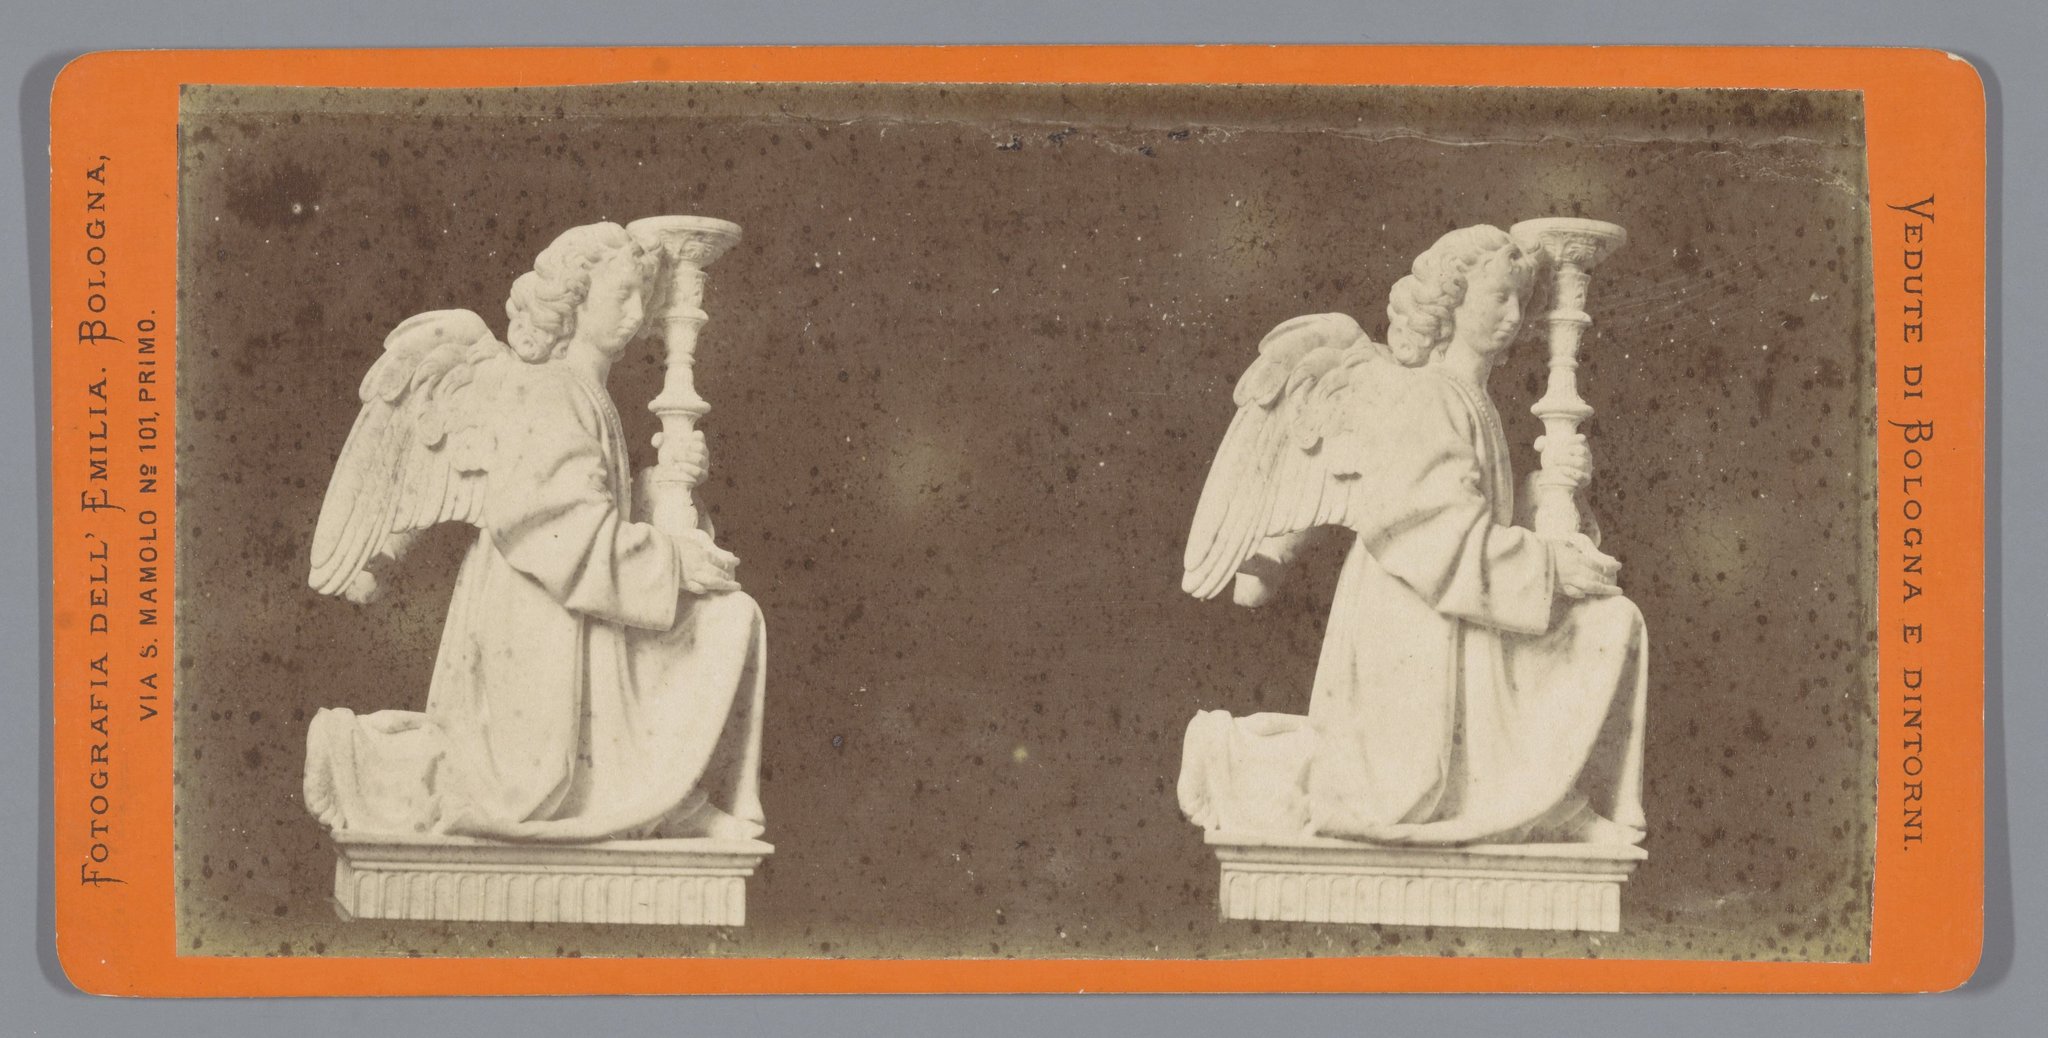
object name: stereograph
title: Vedute di Bologna e Dintorni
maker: Anonymous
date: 1868-1890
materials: cardboard, paper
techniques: albumen print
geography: bologna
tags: angel(s) with torch, piece of sculpture, reproduction of a piece of sculpture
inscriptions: address: ‘Fotografia dell'Emilia. Bologna,/ Via S. Mamolo No 101, Primo’